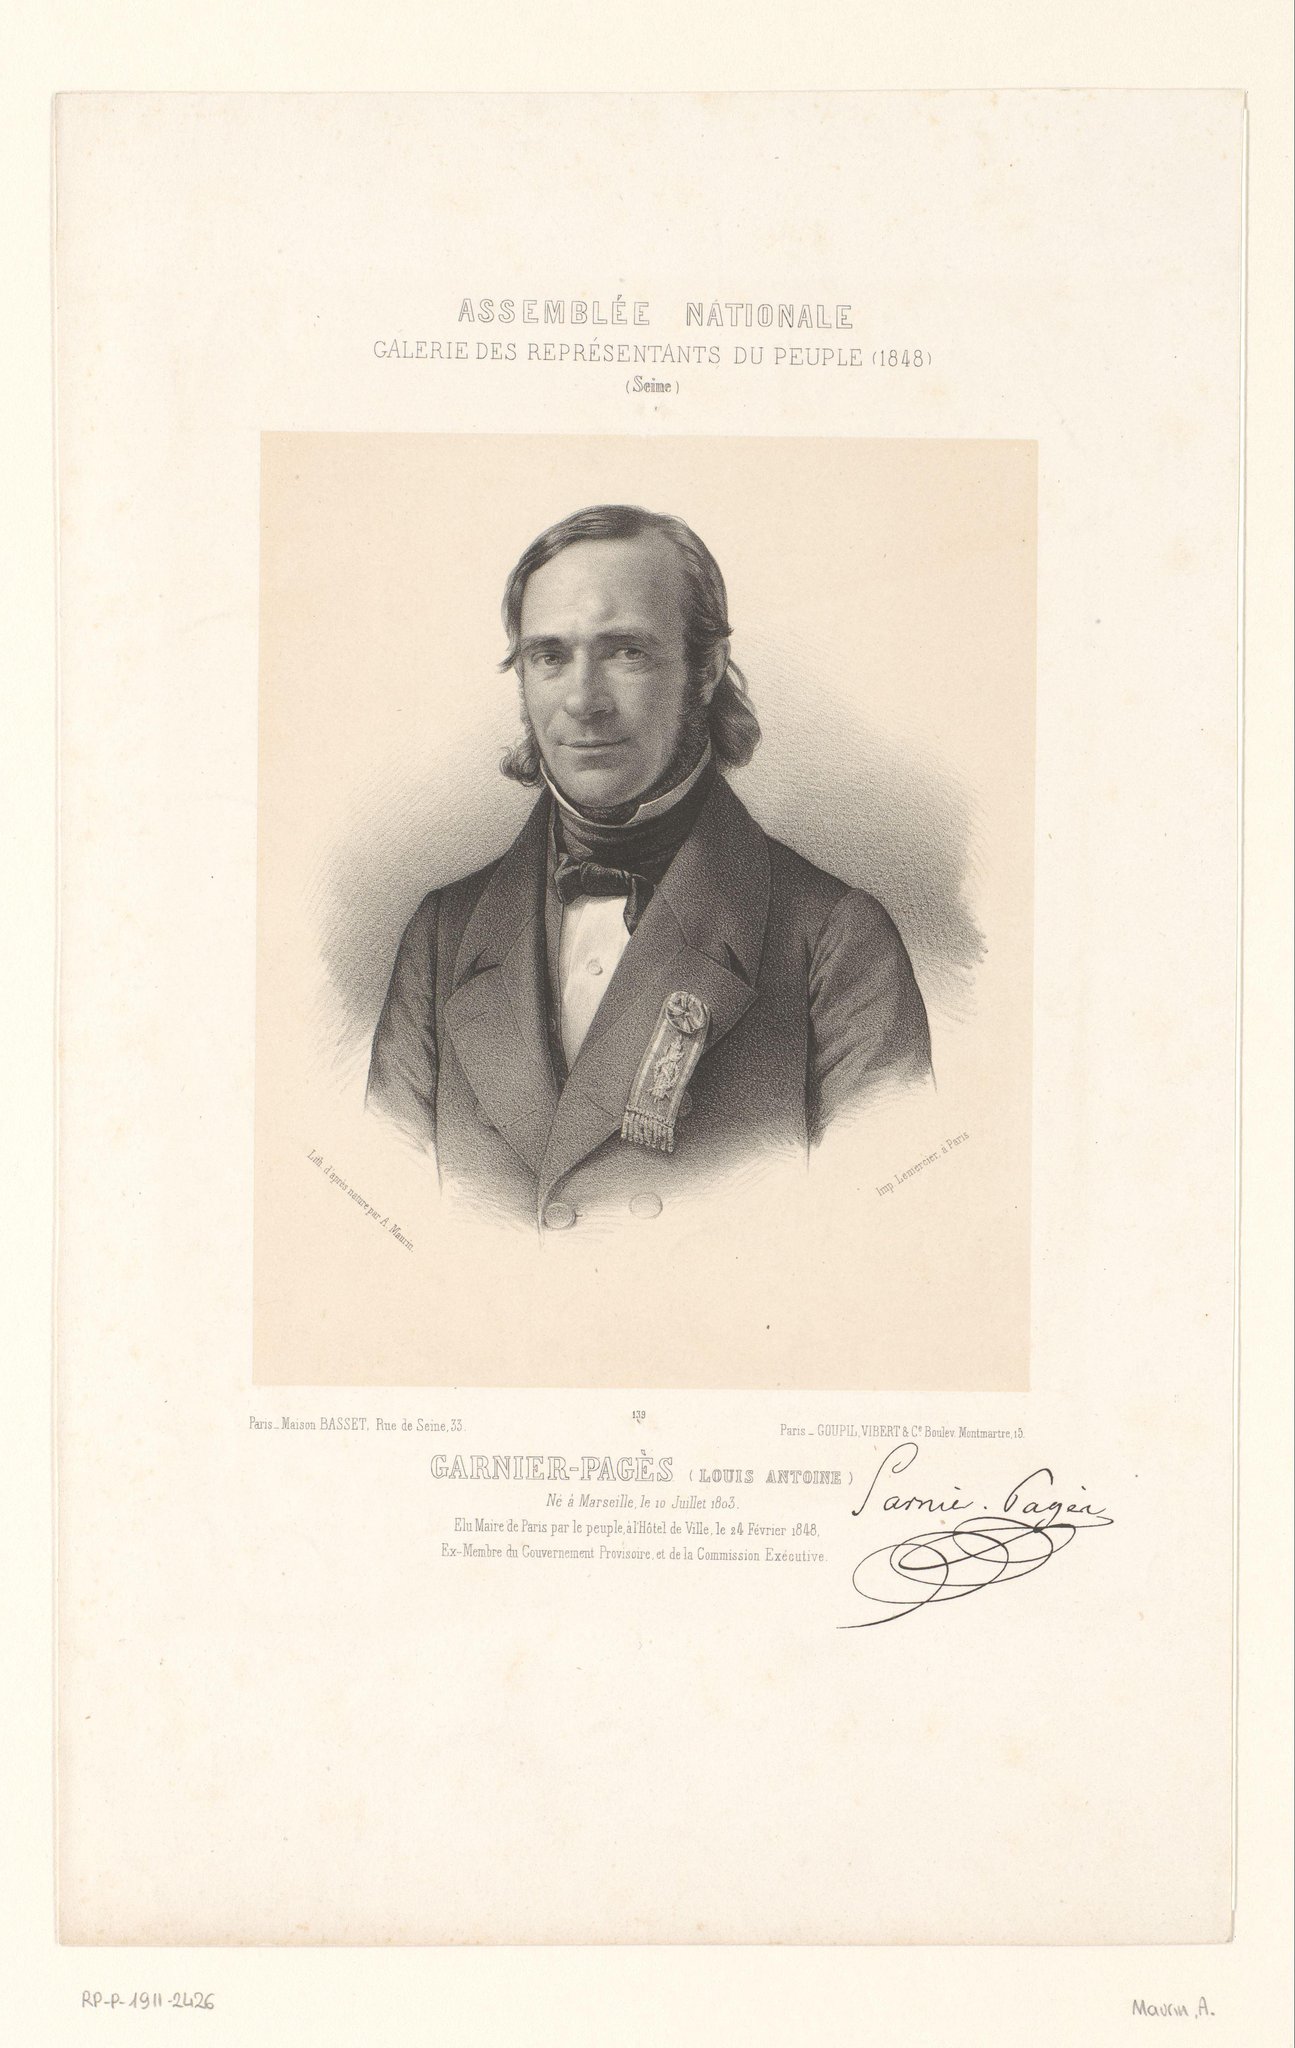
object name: print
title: Portret van politicus Louis-Antoine Garnier-Pagès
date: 1848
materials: paper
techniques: lithograph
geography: paris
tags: paris, historical persons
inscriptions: collector's mark: Lugt 2228